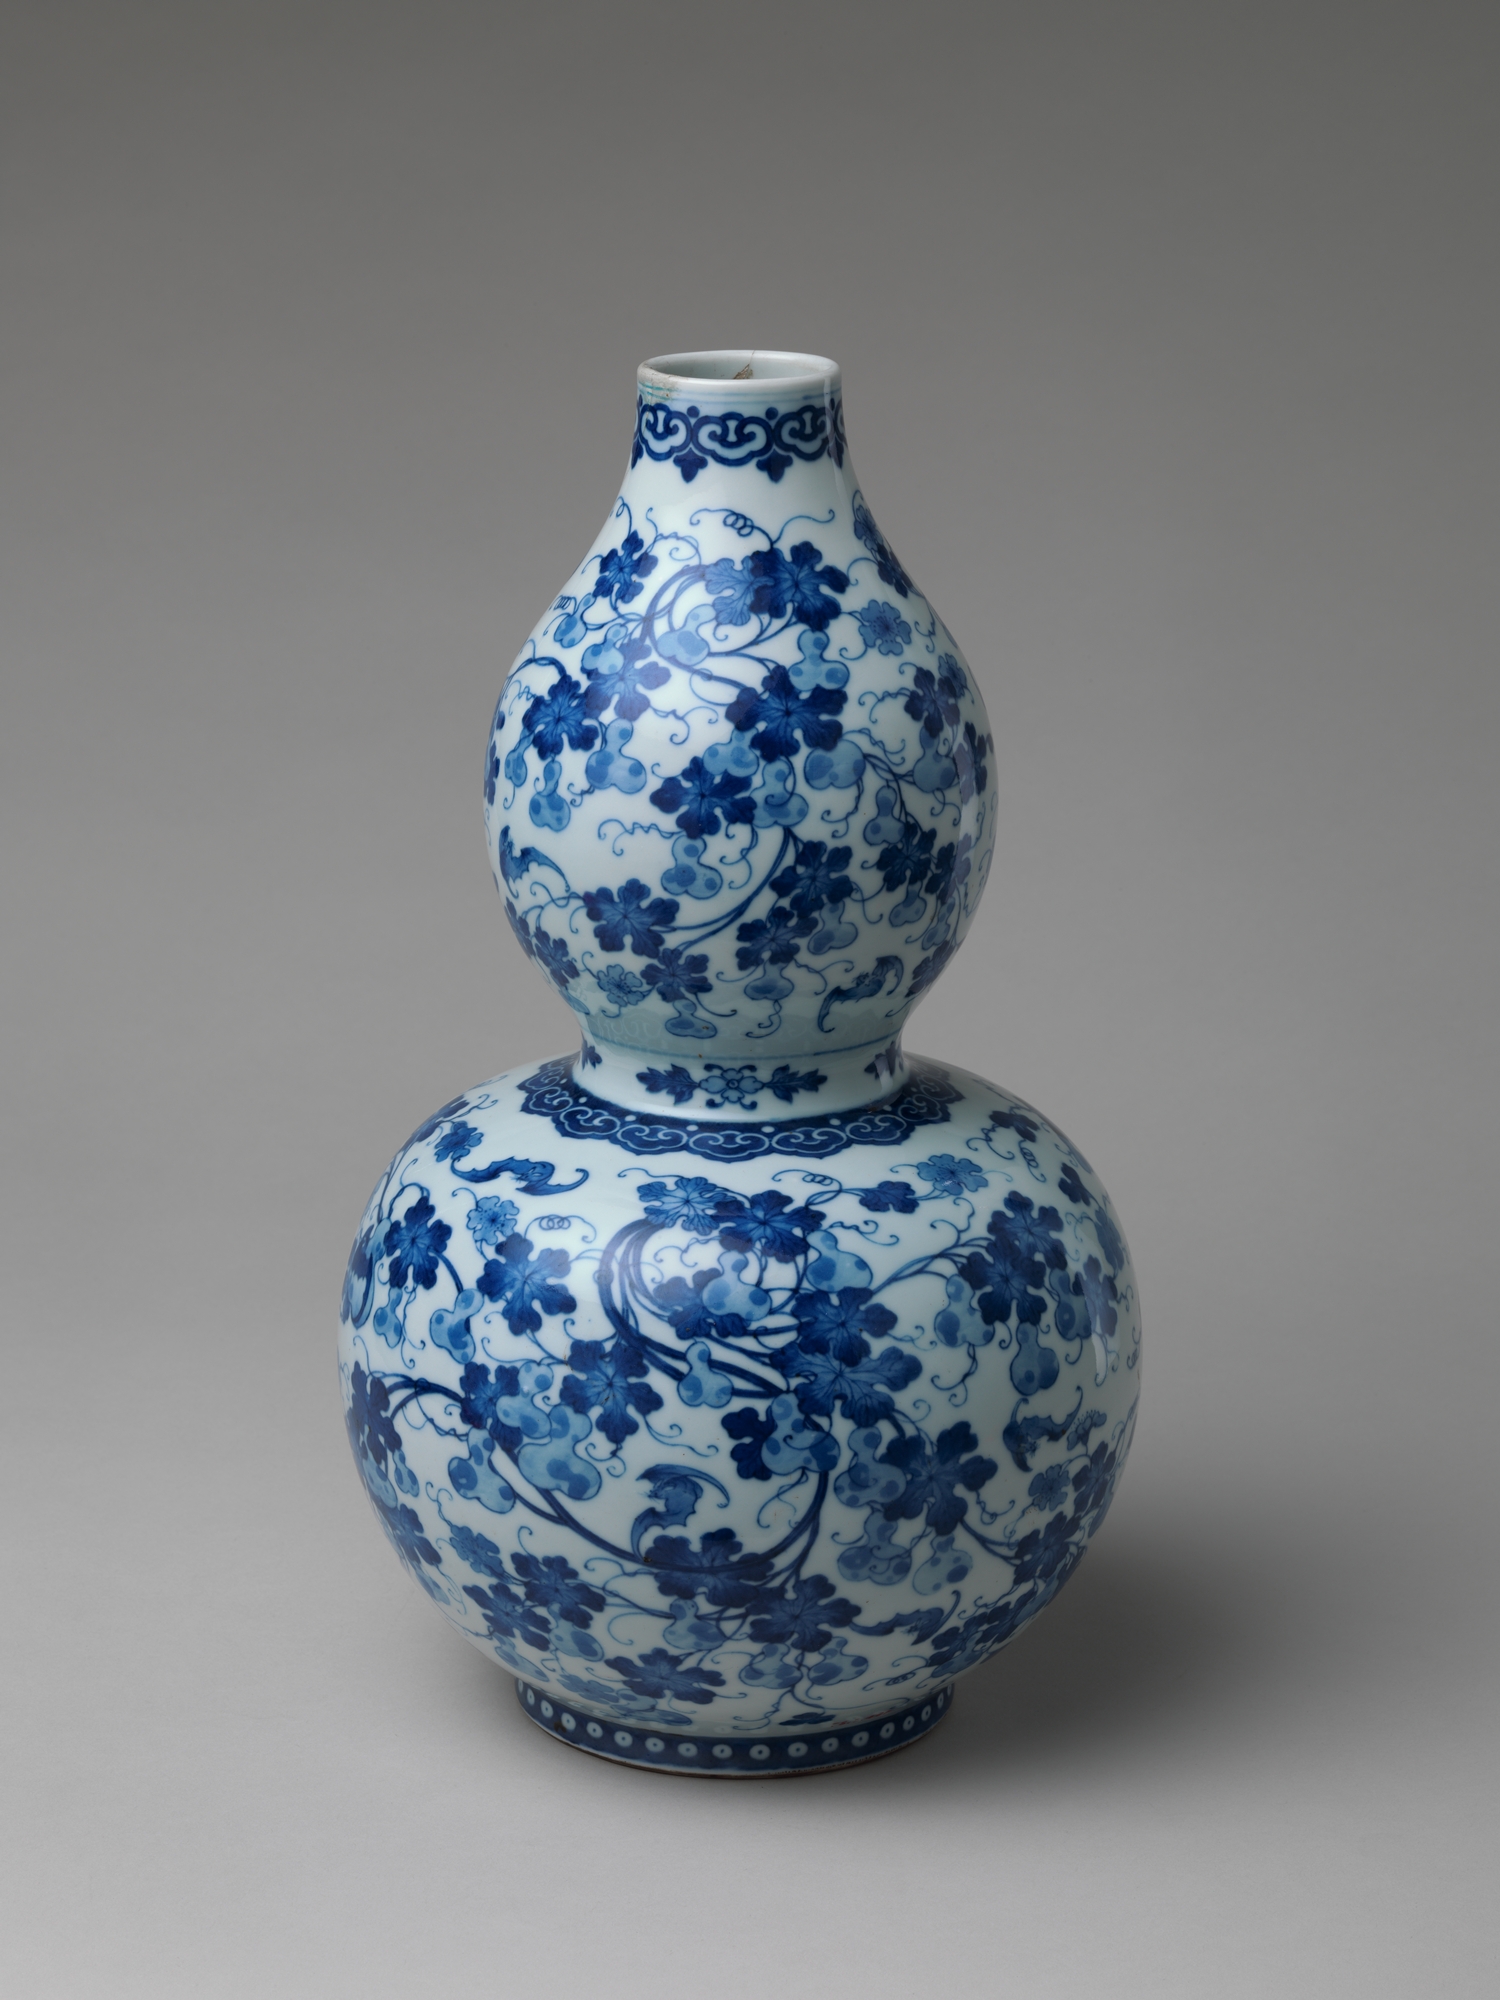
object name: vase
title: Gourd-shaped vase with gourds on vines and bats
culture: chinese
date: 1701-1733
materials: cobalt, porcelain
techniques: painting, underglaze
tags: vegetables,vines